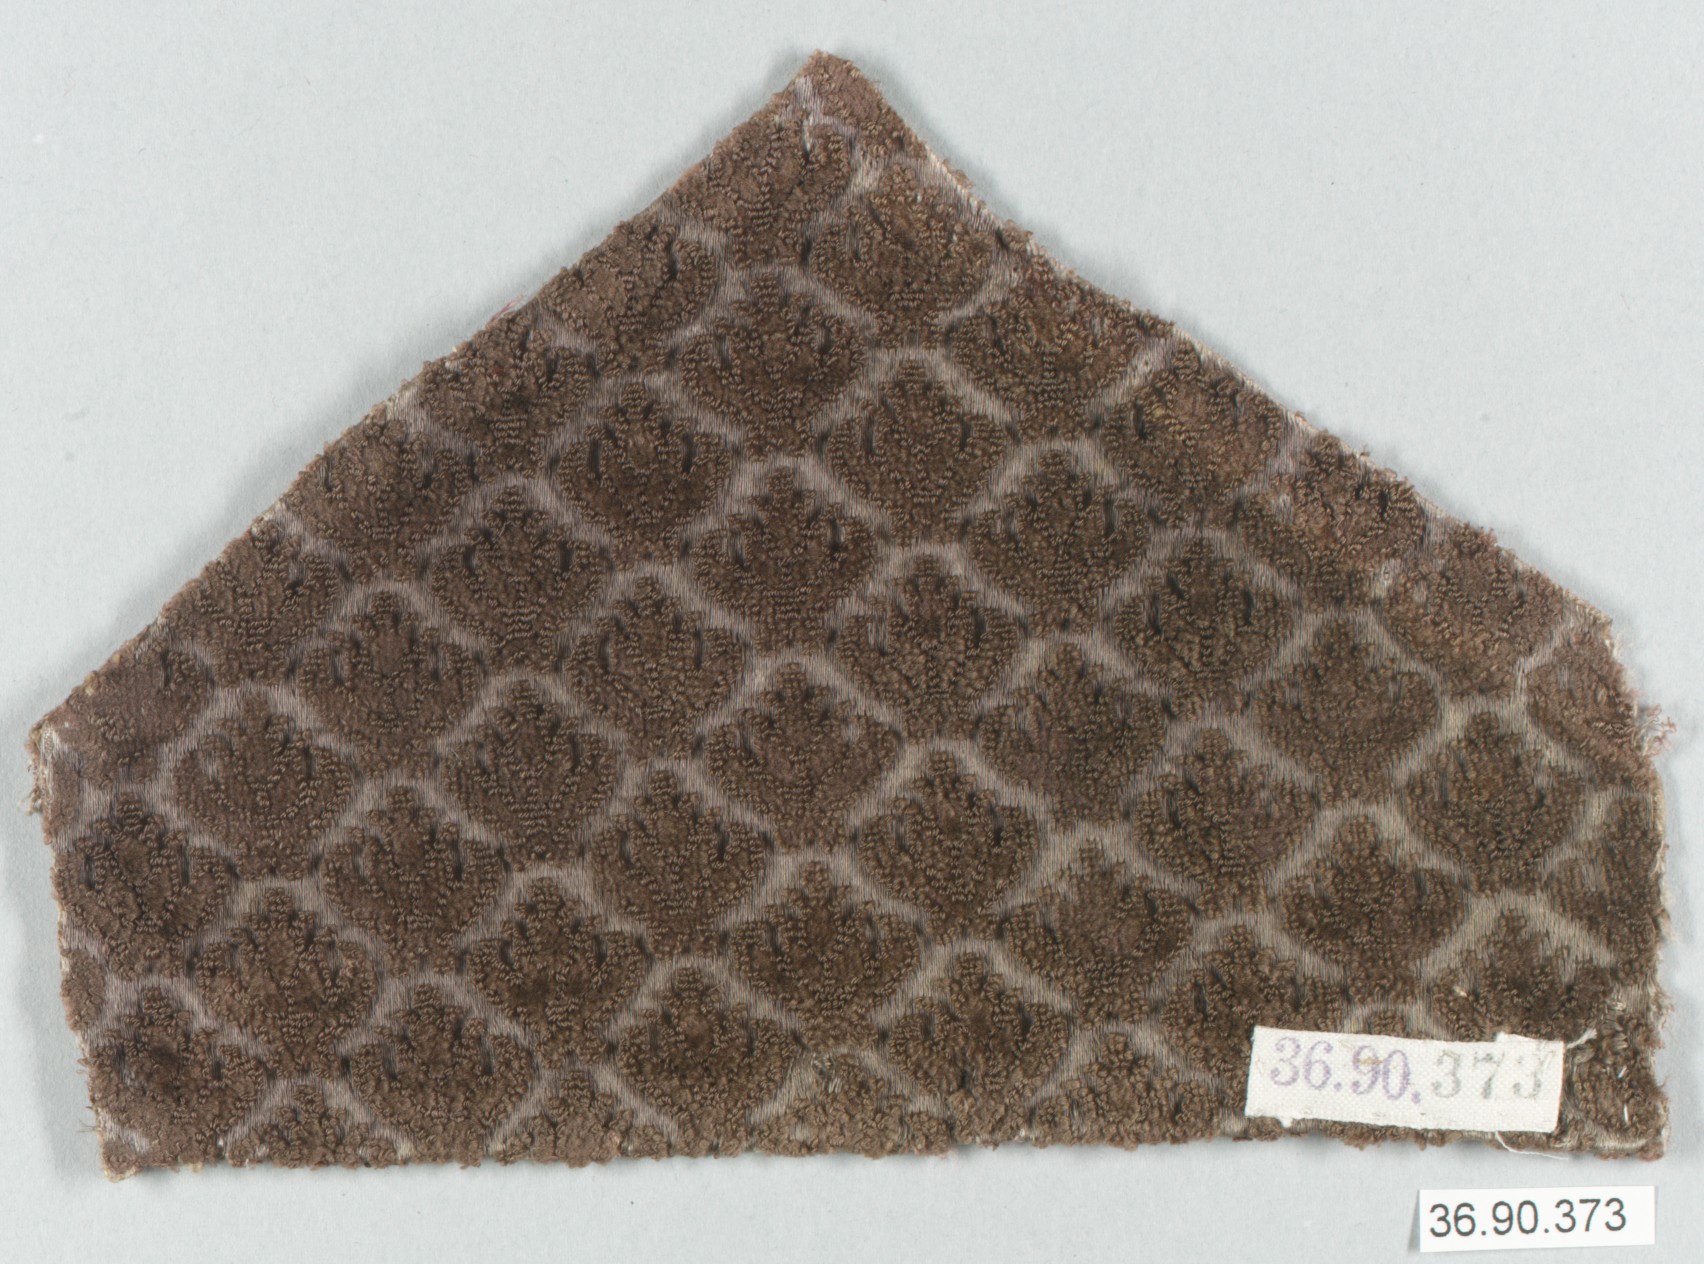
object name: piece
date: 1501-1700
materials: silk